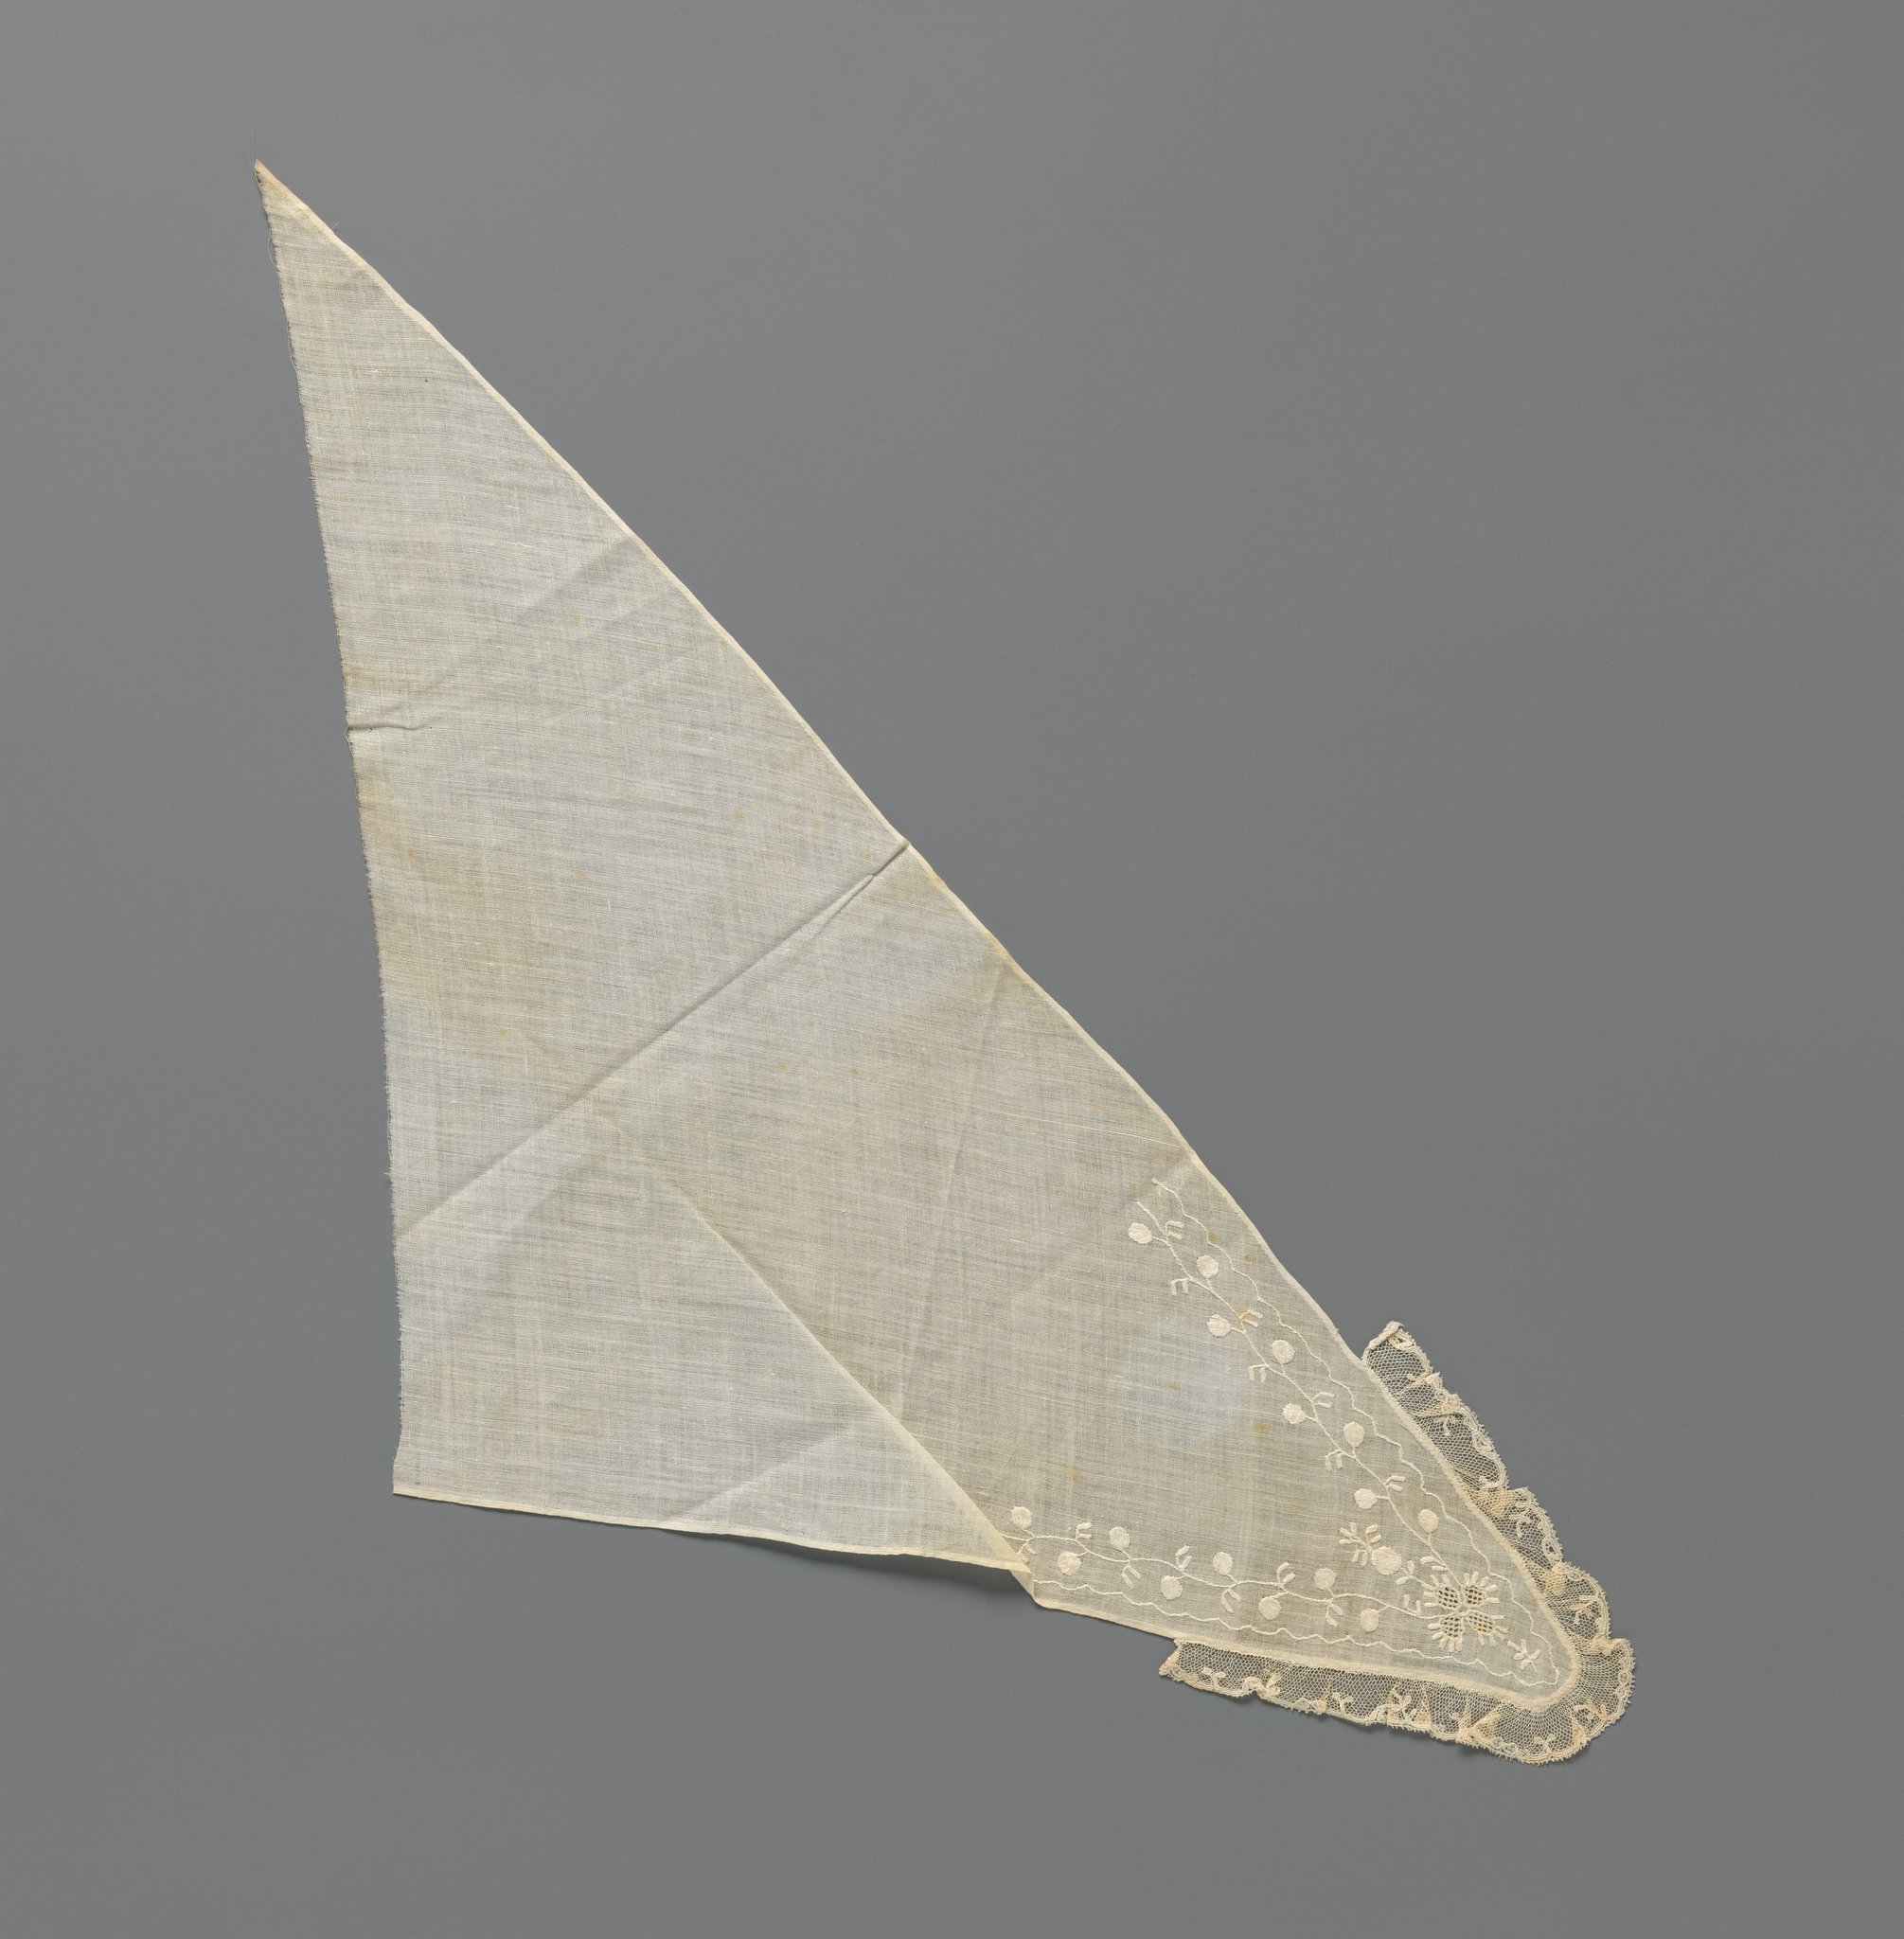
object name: fichu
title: Fichu (deel) van geborduurde batist met kloskant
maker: Anonymous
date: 1850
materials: textile, cotton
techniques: lace, embroidered, weave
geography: france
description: Fichu (deel) van batist met borduurwerk en rond de punt een strookje naturelkleurige kloskant: Rijselse kant. Aan het deel van de fichu zit één versierde hoek, de andere hoeken zijn onversierd en betreffen een afgeknipt en onafgewerkt deel. De versierde punt is geborduurd met een bloem met vier bloembladeren met open naaiwerk waaruit ijle bloemstengels ontspringen die zich een stukje langs de twee zijden van de hoek voortzetten. Het kant rond de punt is korter dan het borduurwerk met de bloemstengels en heeft een minimaal patroon van takken en ovalen langs de rand.